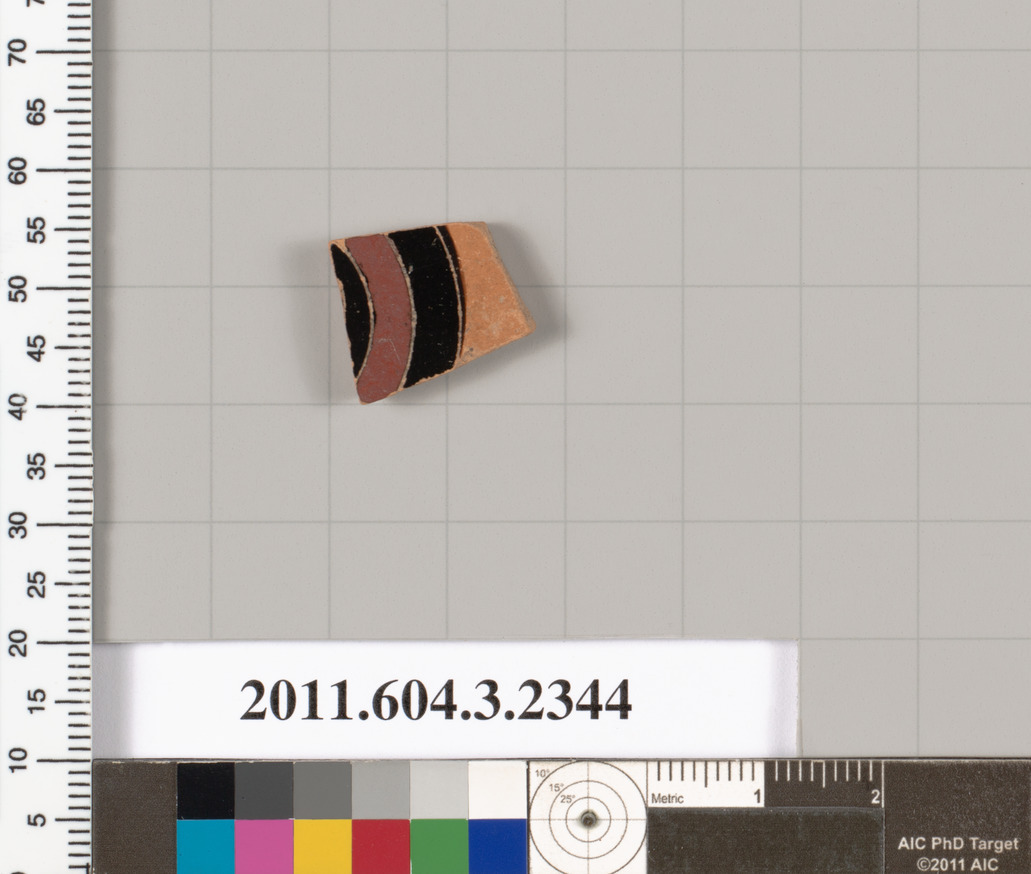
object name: kylix fragment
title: Terracotta fragment of a kylix: eye-cup (drinking cup)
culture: greek, attic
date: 540-520 BCE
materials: terracotta